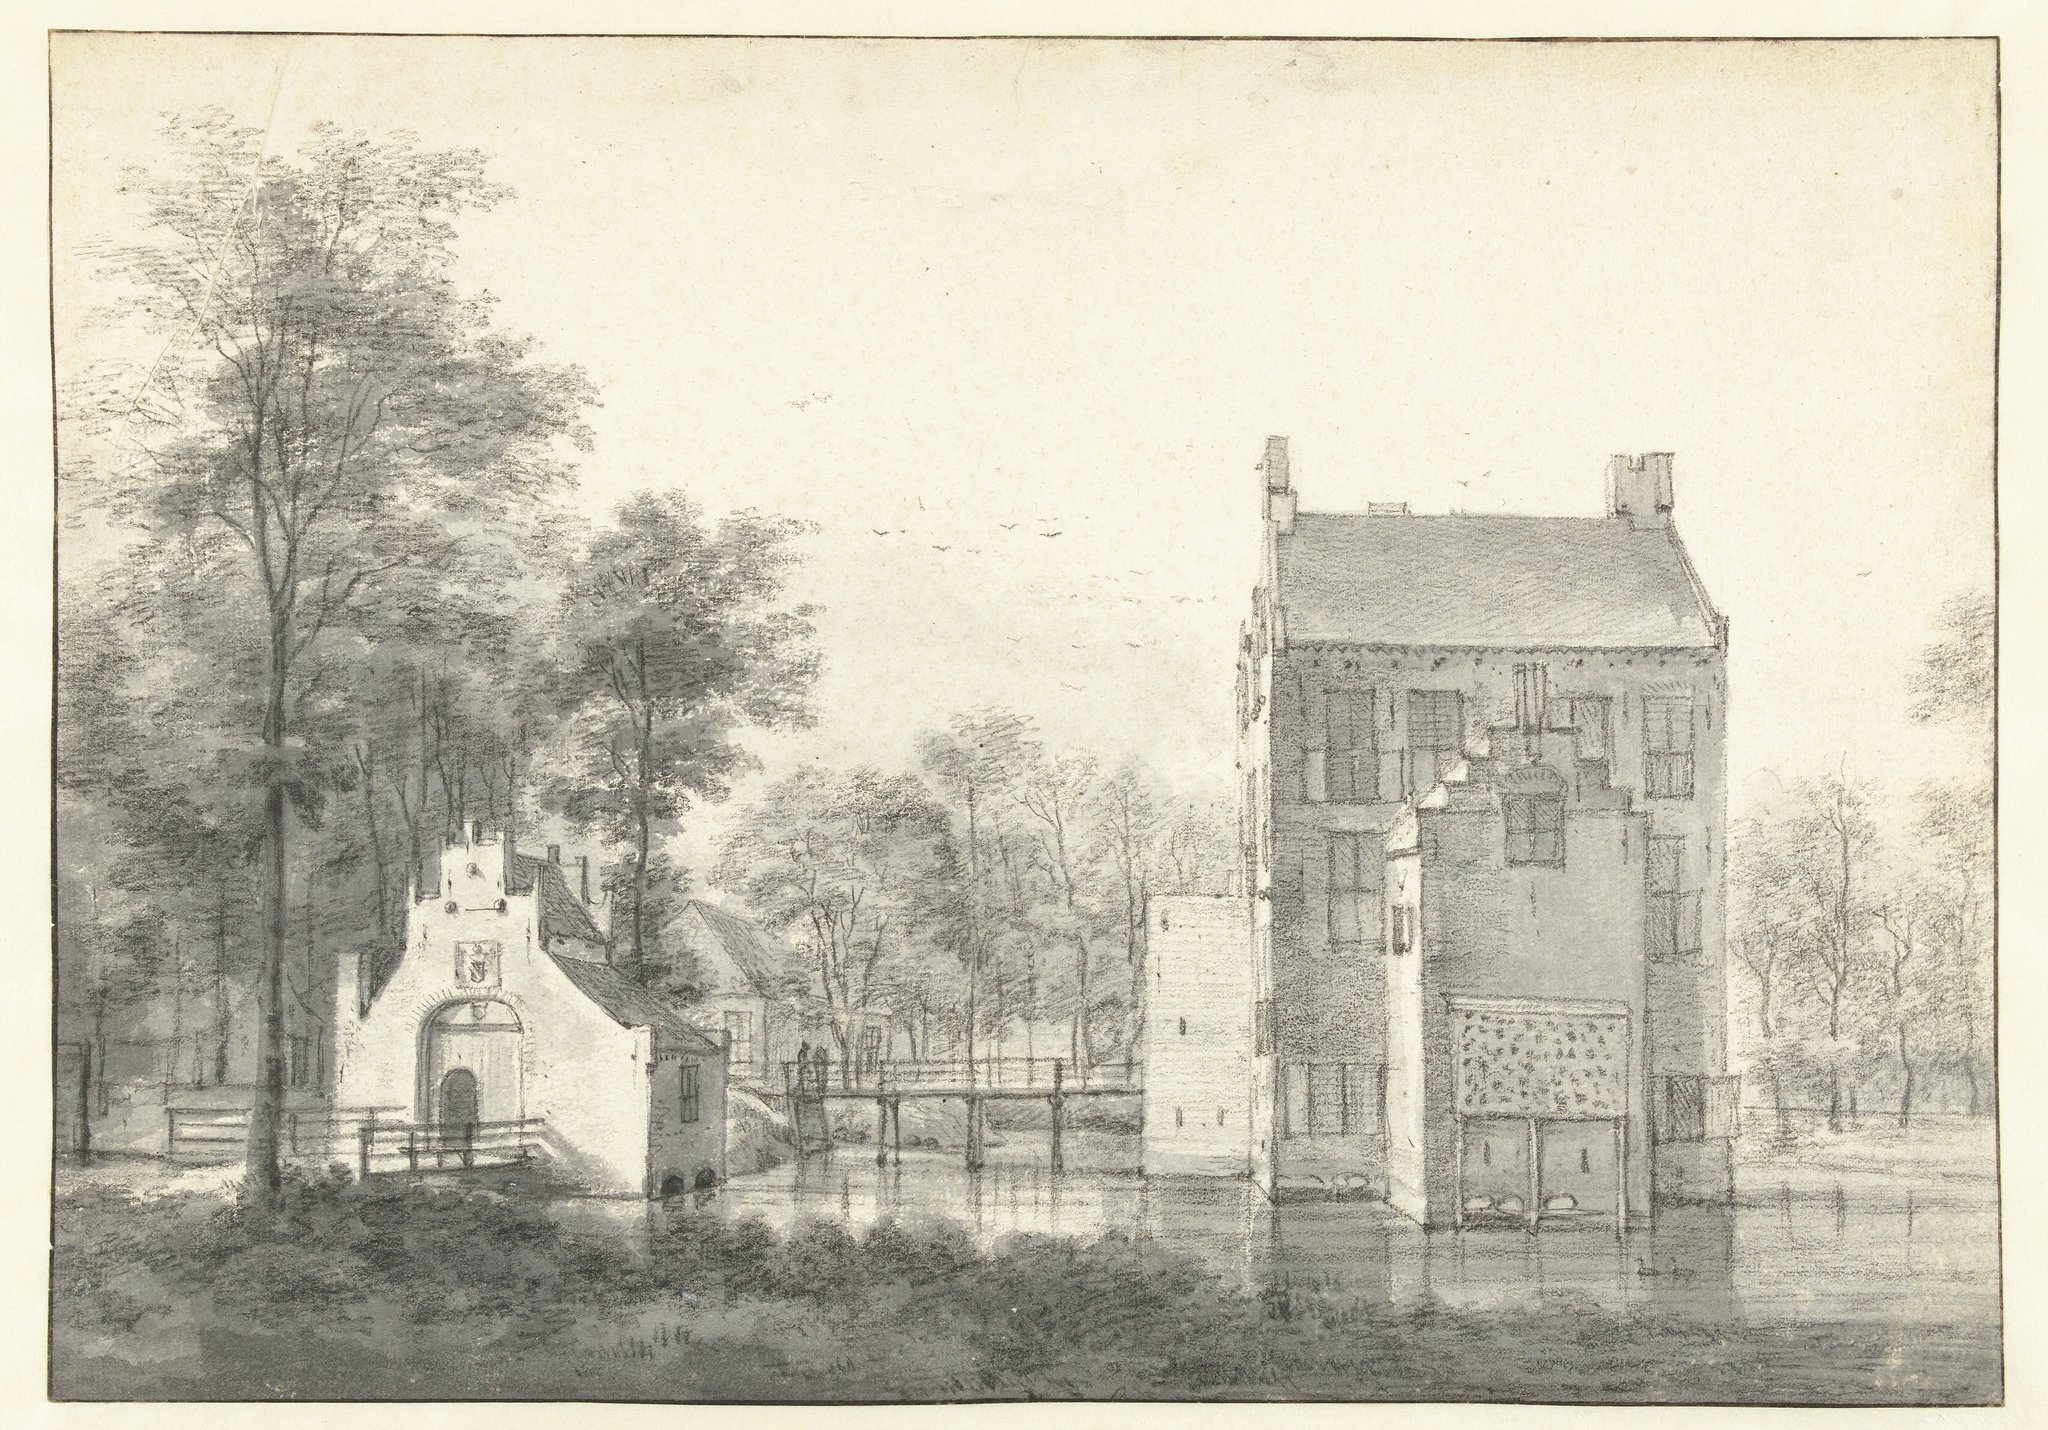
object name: drawing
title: View of Huis Groenewoude, Seen from the East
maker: roelant roghman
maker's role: draughtsman, painter, print maker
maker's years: 1627-1692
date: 1646-1650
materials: chalk, ink, paper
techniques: brush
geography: woudenberg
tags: castle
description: Gezicht op het kasteel Groenewoude bij Woudenberg uit het oosten, met links het poortgebouw dat toegang gaf tot de voorburcht.